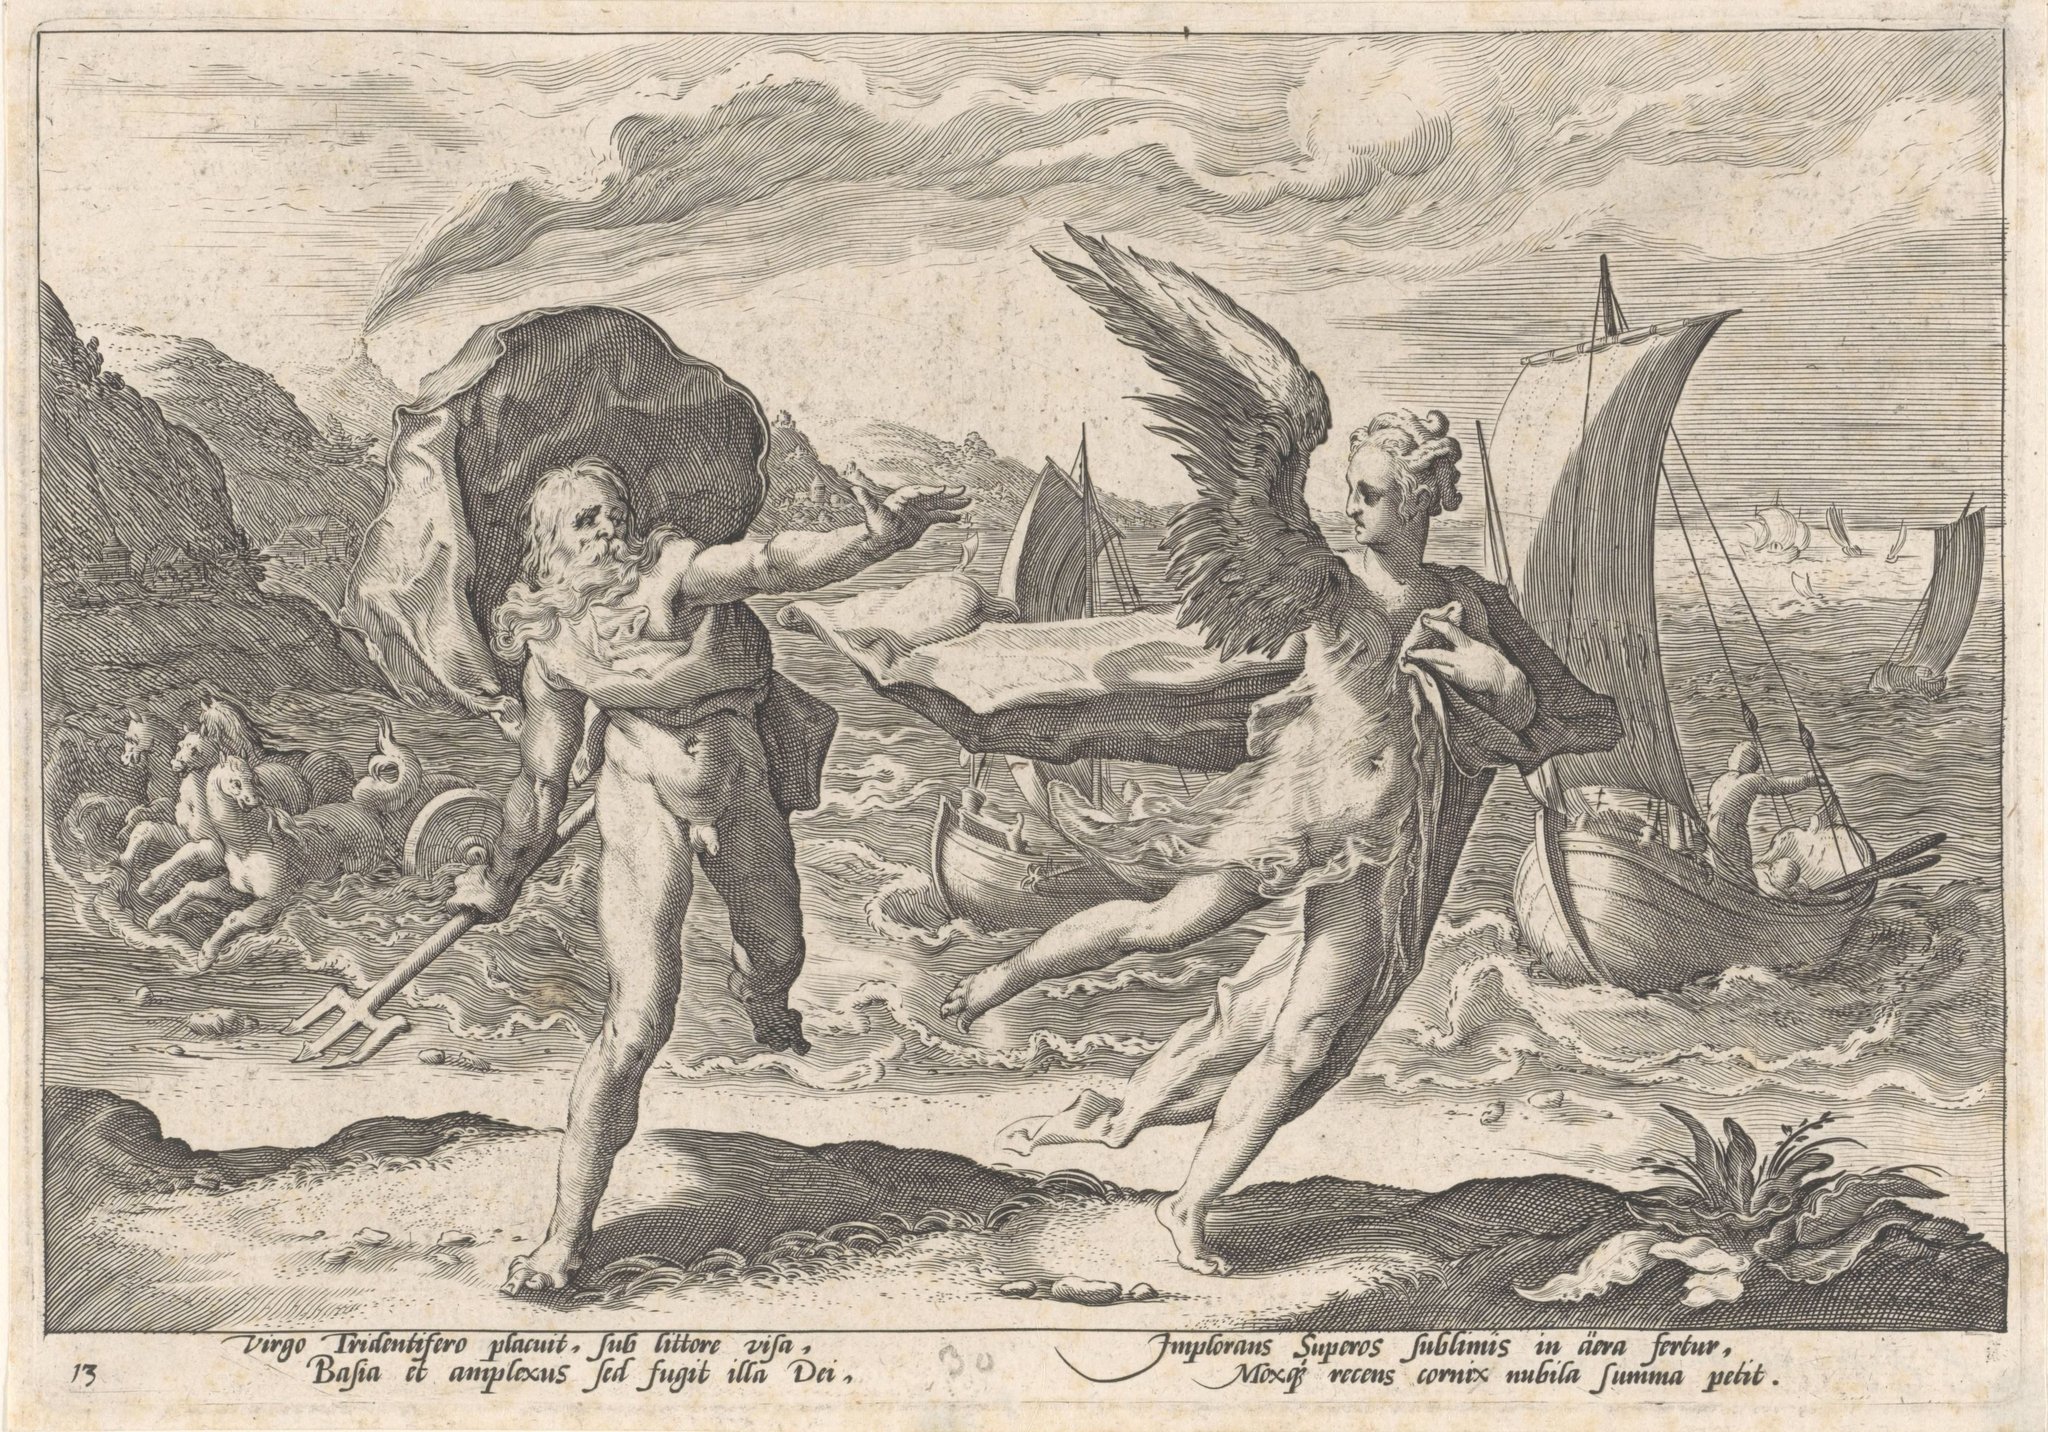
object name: print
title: Coronis verandert in een kraai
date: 1590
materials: paper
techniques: engraving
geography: haarlem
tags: coronis changed into a crow: to escape the love of neptune, coronis, daughter of coroneus, is changed into a crow by minerva (ovid, metamorphoses ii 569)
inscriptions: collector's mark: ‘Hinloopen’, collector's mark: Lugt 11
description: Neptunus achtervolgt Coronis, de dochter van Coroneus, op wie hij verliefd is geworden. Om haar te redden, verandert Minerva Coronis in een kraai. Op de achtergrond de wagen van Neptunus en schepen. In de ondermarge een vierregelige toelichting, in twee kolommen, in het Latijn.